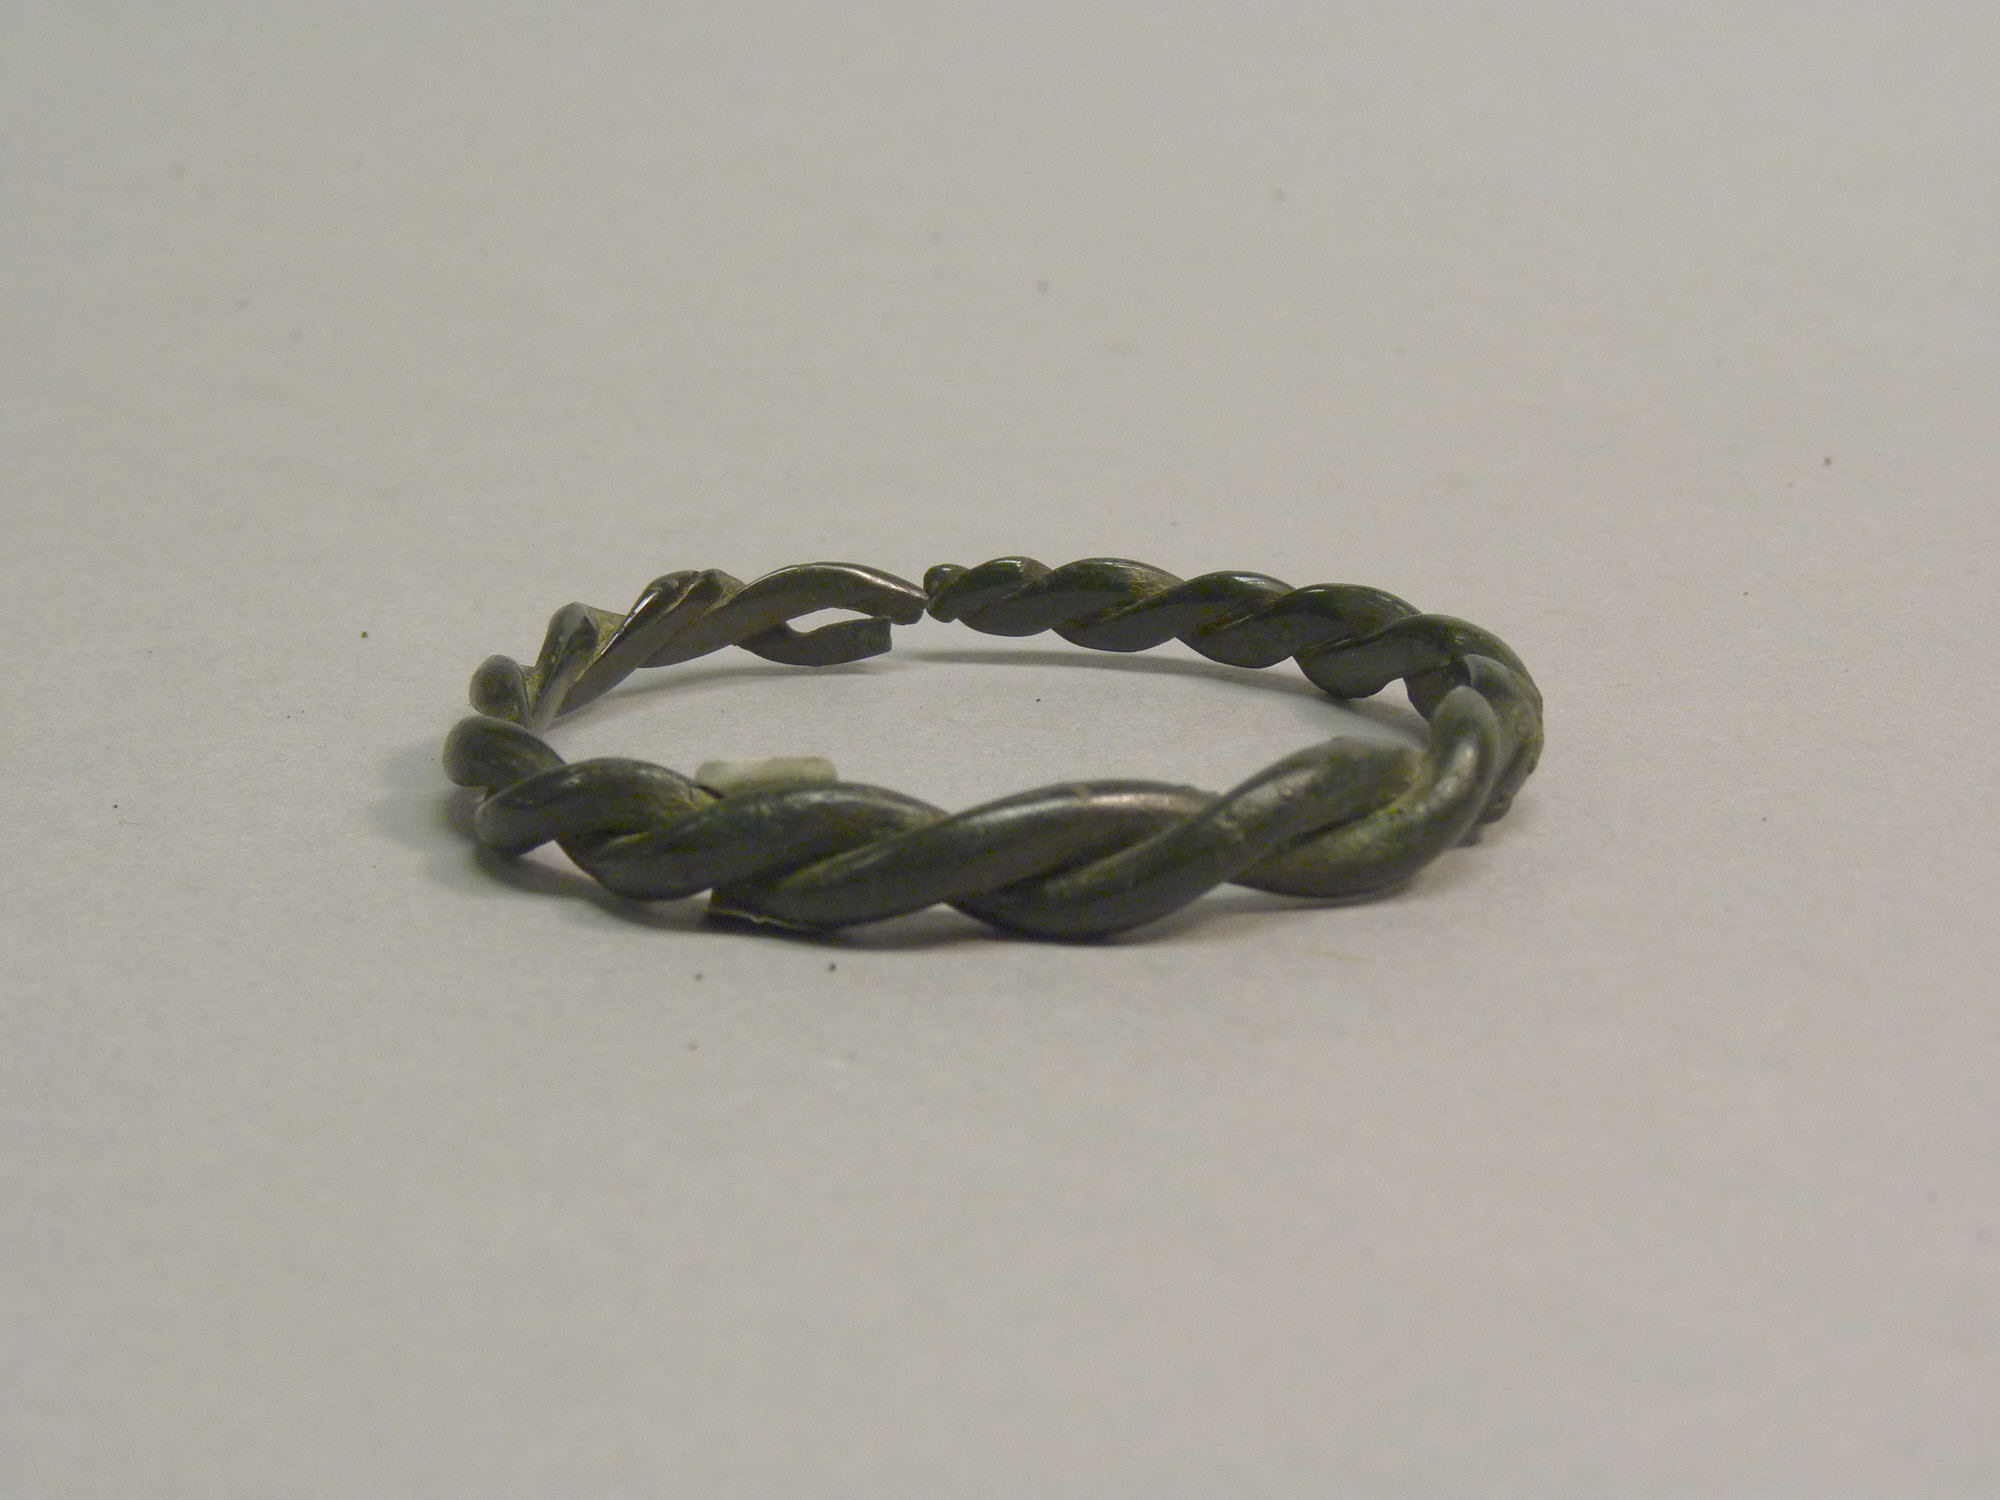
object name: bangle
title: Twisted Bangle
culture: thai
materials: bronze